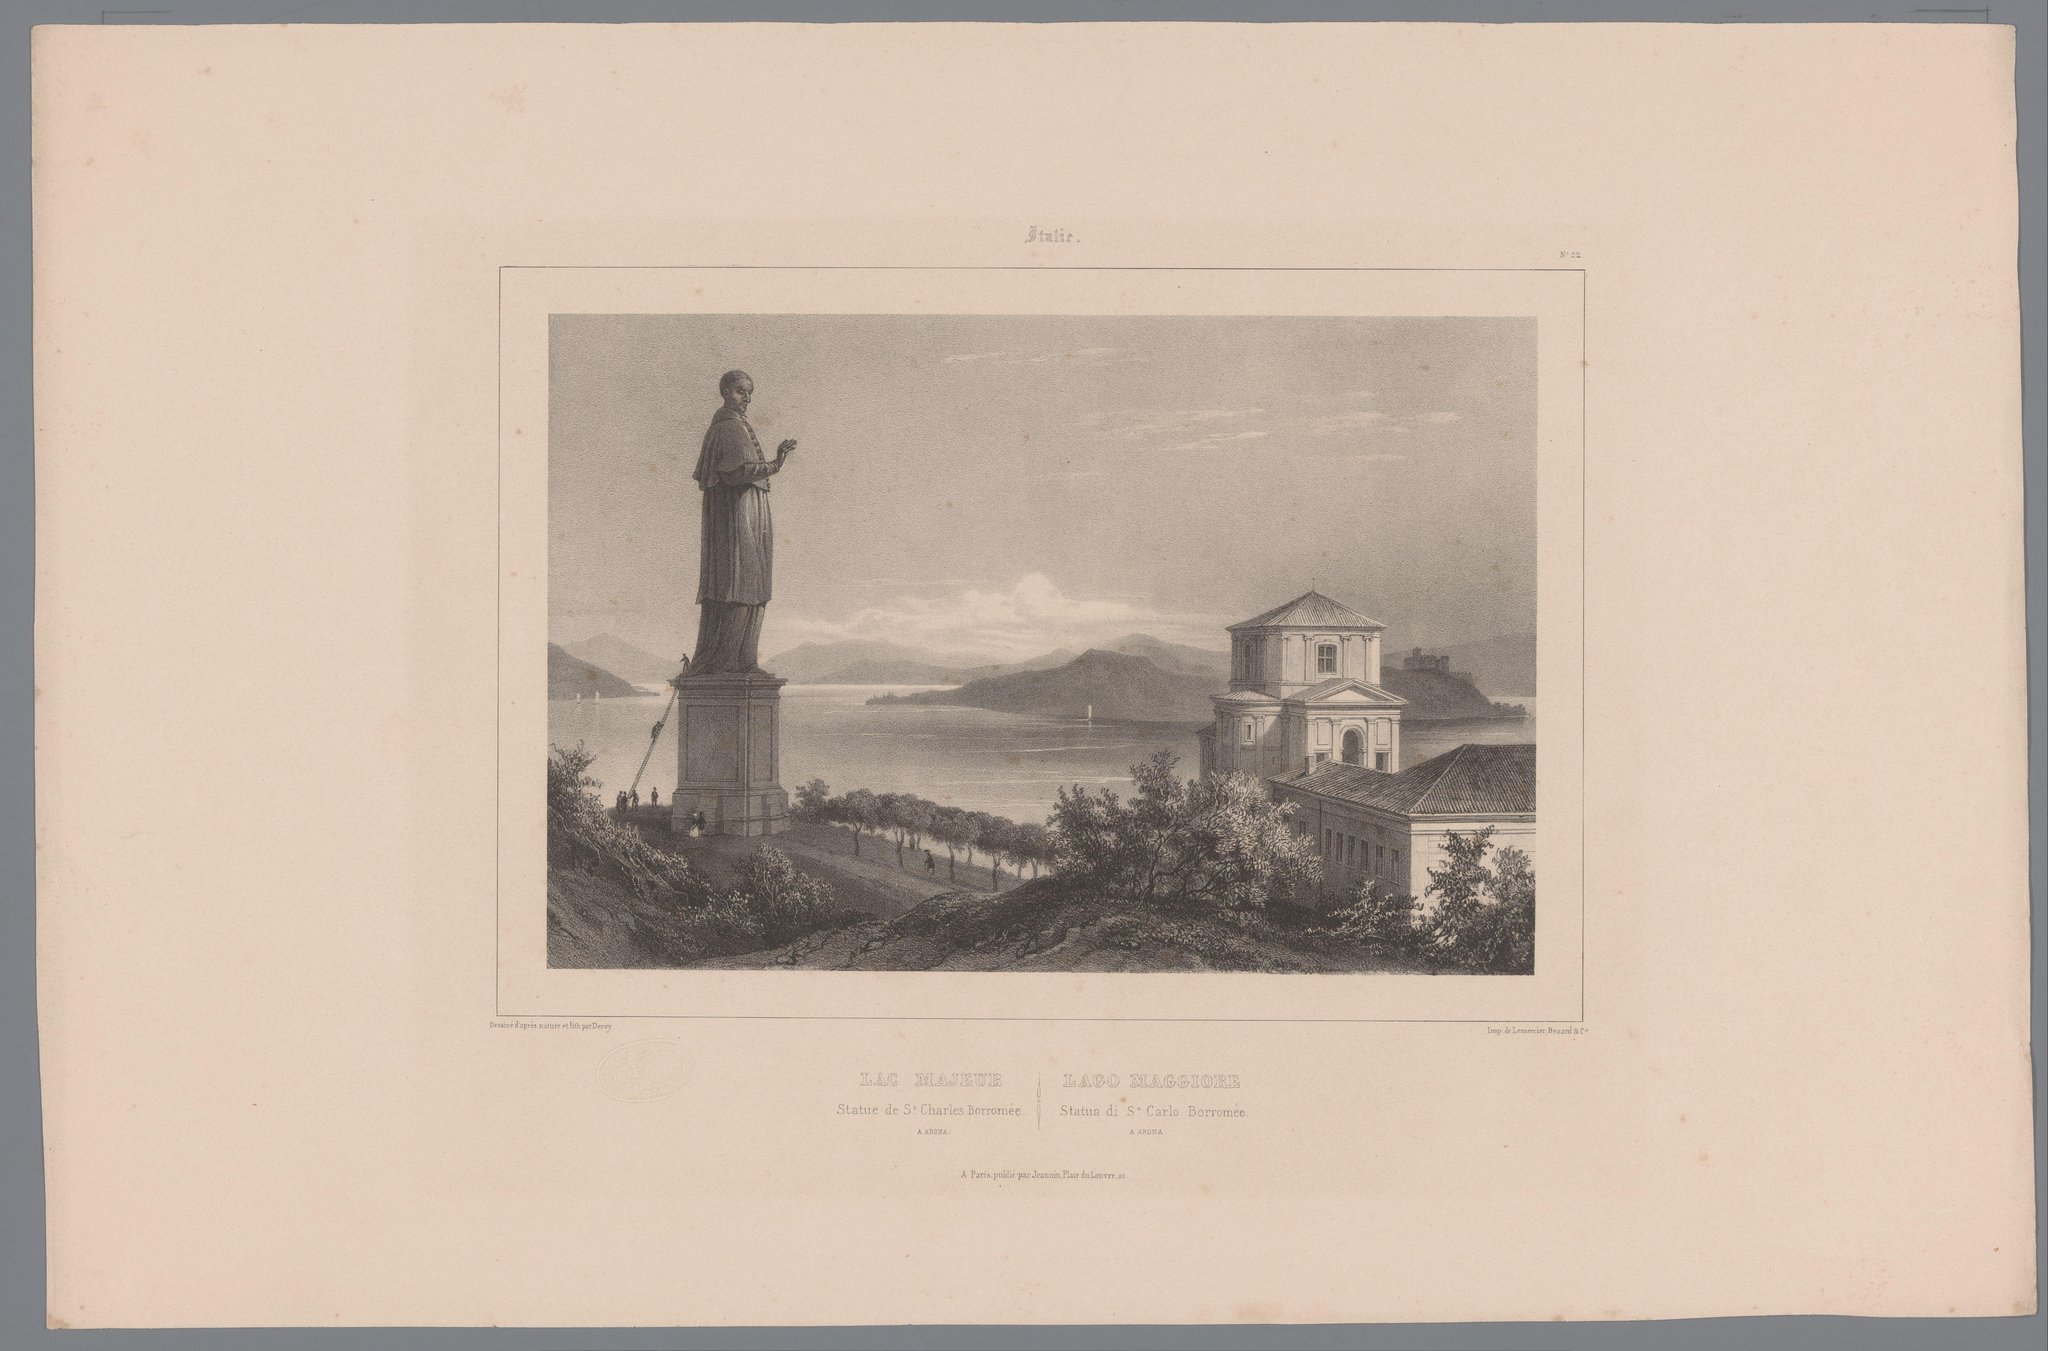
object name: print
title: Gezichten in Italië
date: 1838-1841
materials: paper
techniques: lithograph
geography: paris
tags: charles borromeo, cardinal of milan; possible attributes: cardinal's hat, crucifix, rope round his neck, skull, monument, statue, lake (+ landscape with figures, staffage)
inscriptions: collector's mark: Lugt 2228a, check stamp: Lugt 1397c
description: Prent maakt deel uit van een omslag met zes prenten.